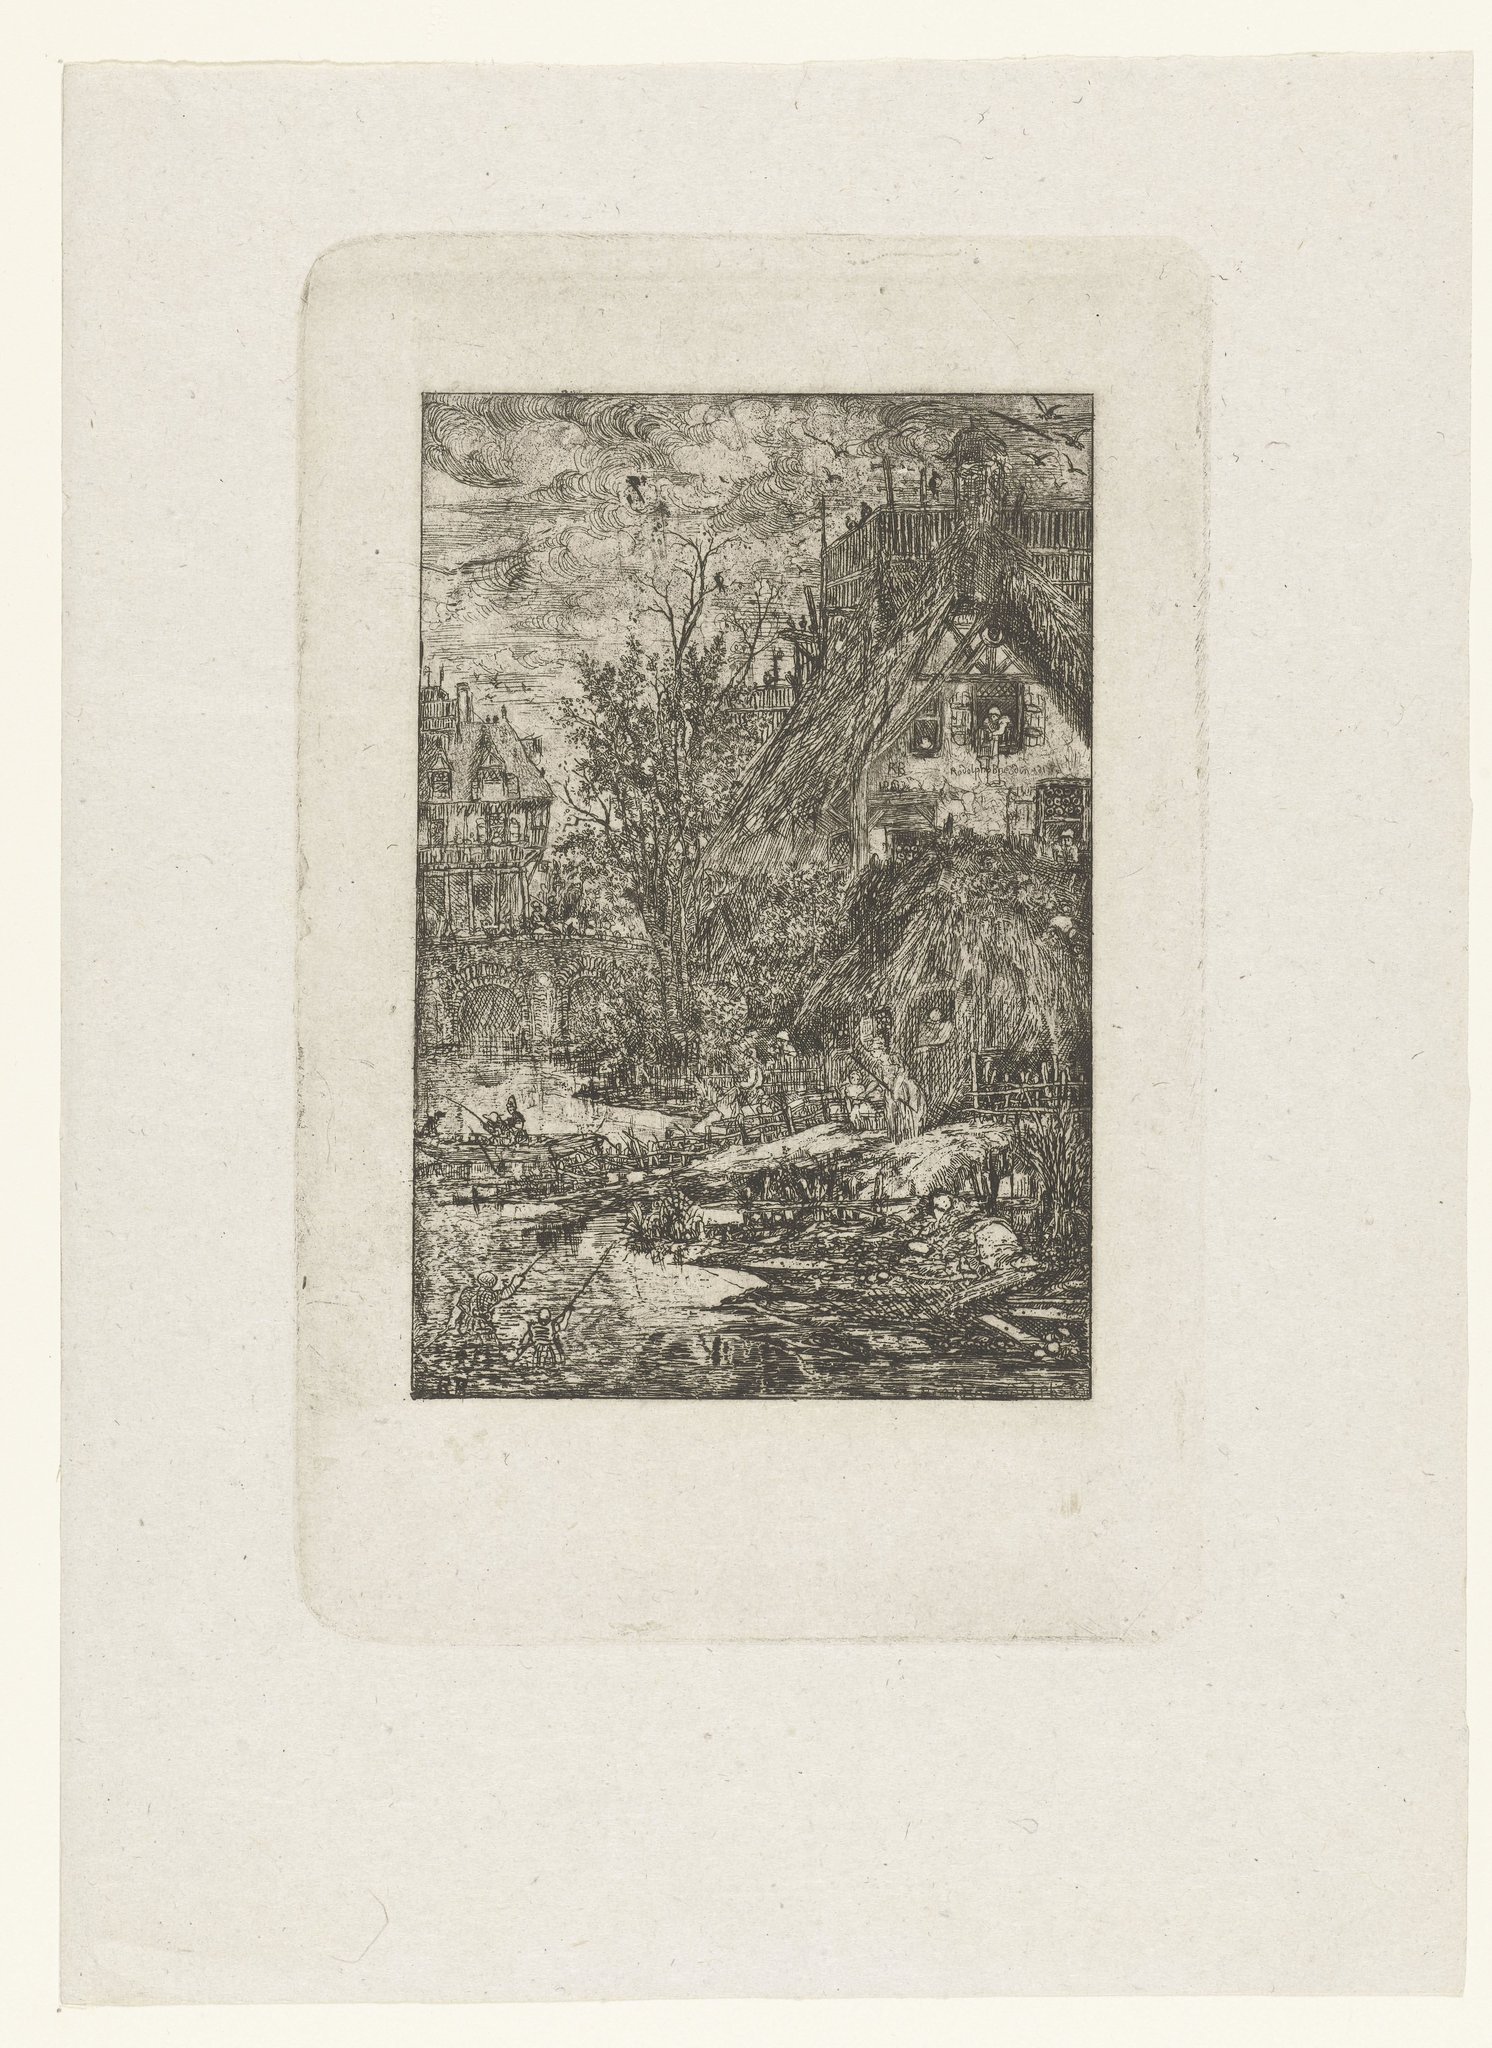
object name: print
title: Dorpsgezicht met rivier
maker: rodolphe bresdin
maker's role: draughtsman, print maker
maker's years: 1822-1885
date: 1861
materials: paper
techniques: etching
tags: village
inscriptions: collector's mark: Lugt 2228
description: Dorpsgezicht met een rivier. Rechts op de oever staan huizen op een rij langs de rivier die met een bocht links onder een brug het dorp in loopt. Op de voorgrond staan vissers met hengels in het ondiepe water.